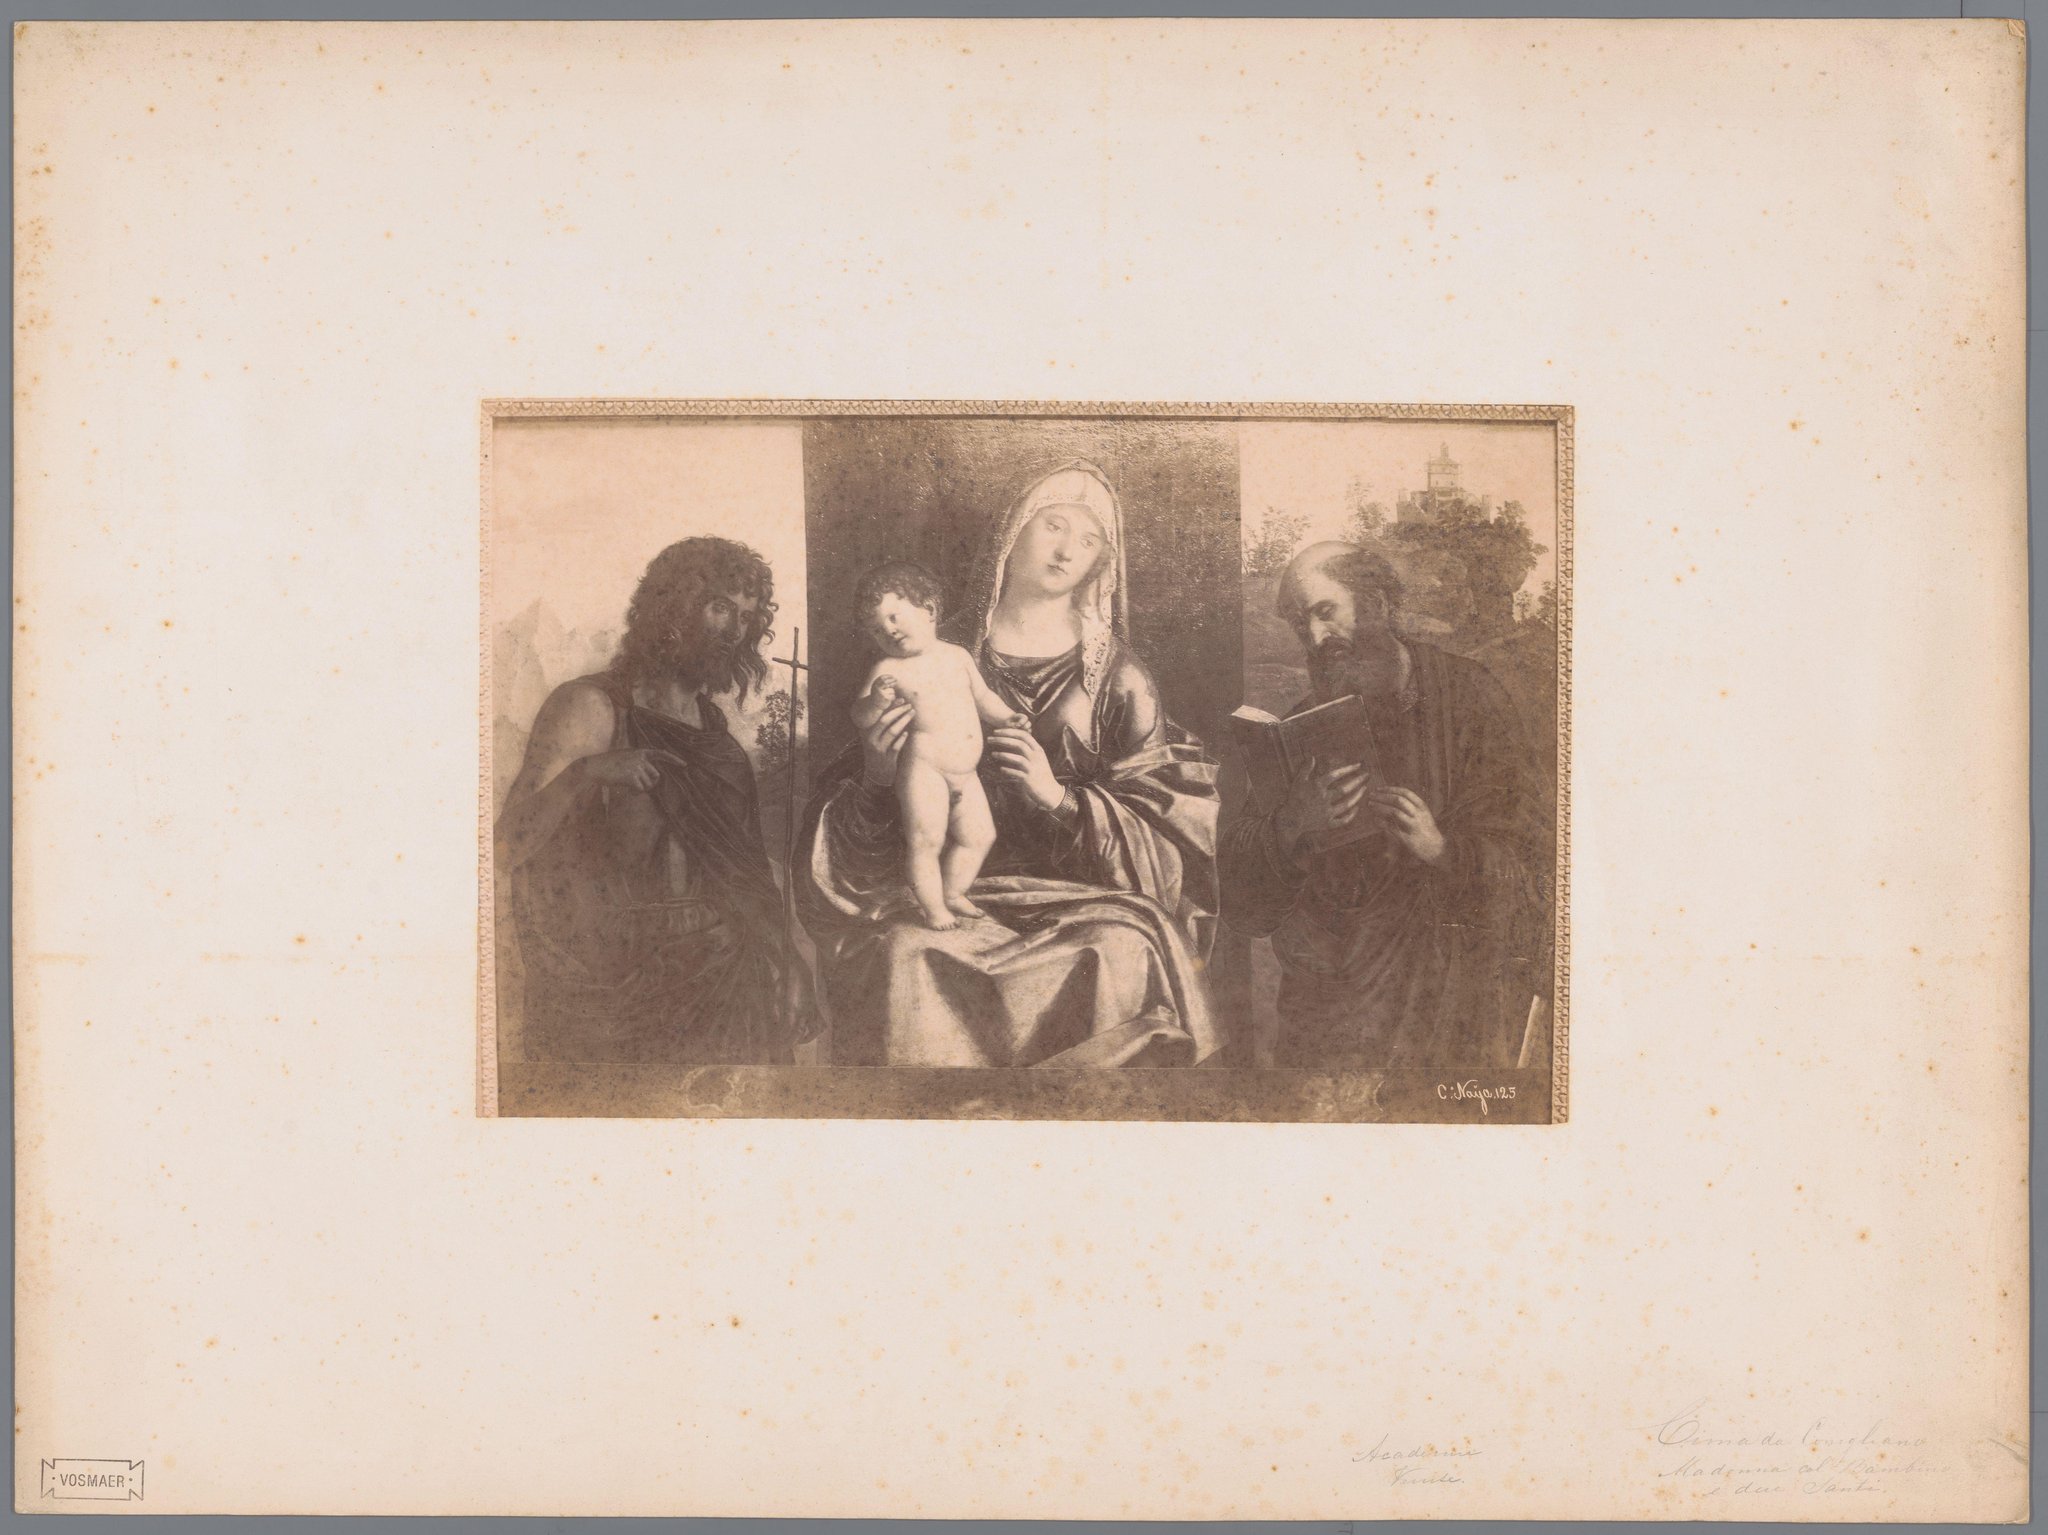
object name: photograph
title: 125 [in negatief]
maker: carlo naya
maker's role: fotograaf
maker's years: 1816-1882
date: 1860-1880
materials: cardboard, paper, photographic support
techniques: albumen print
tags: picture, painting, venice